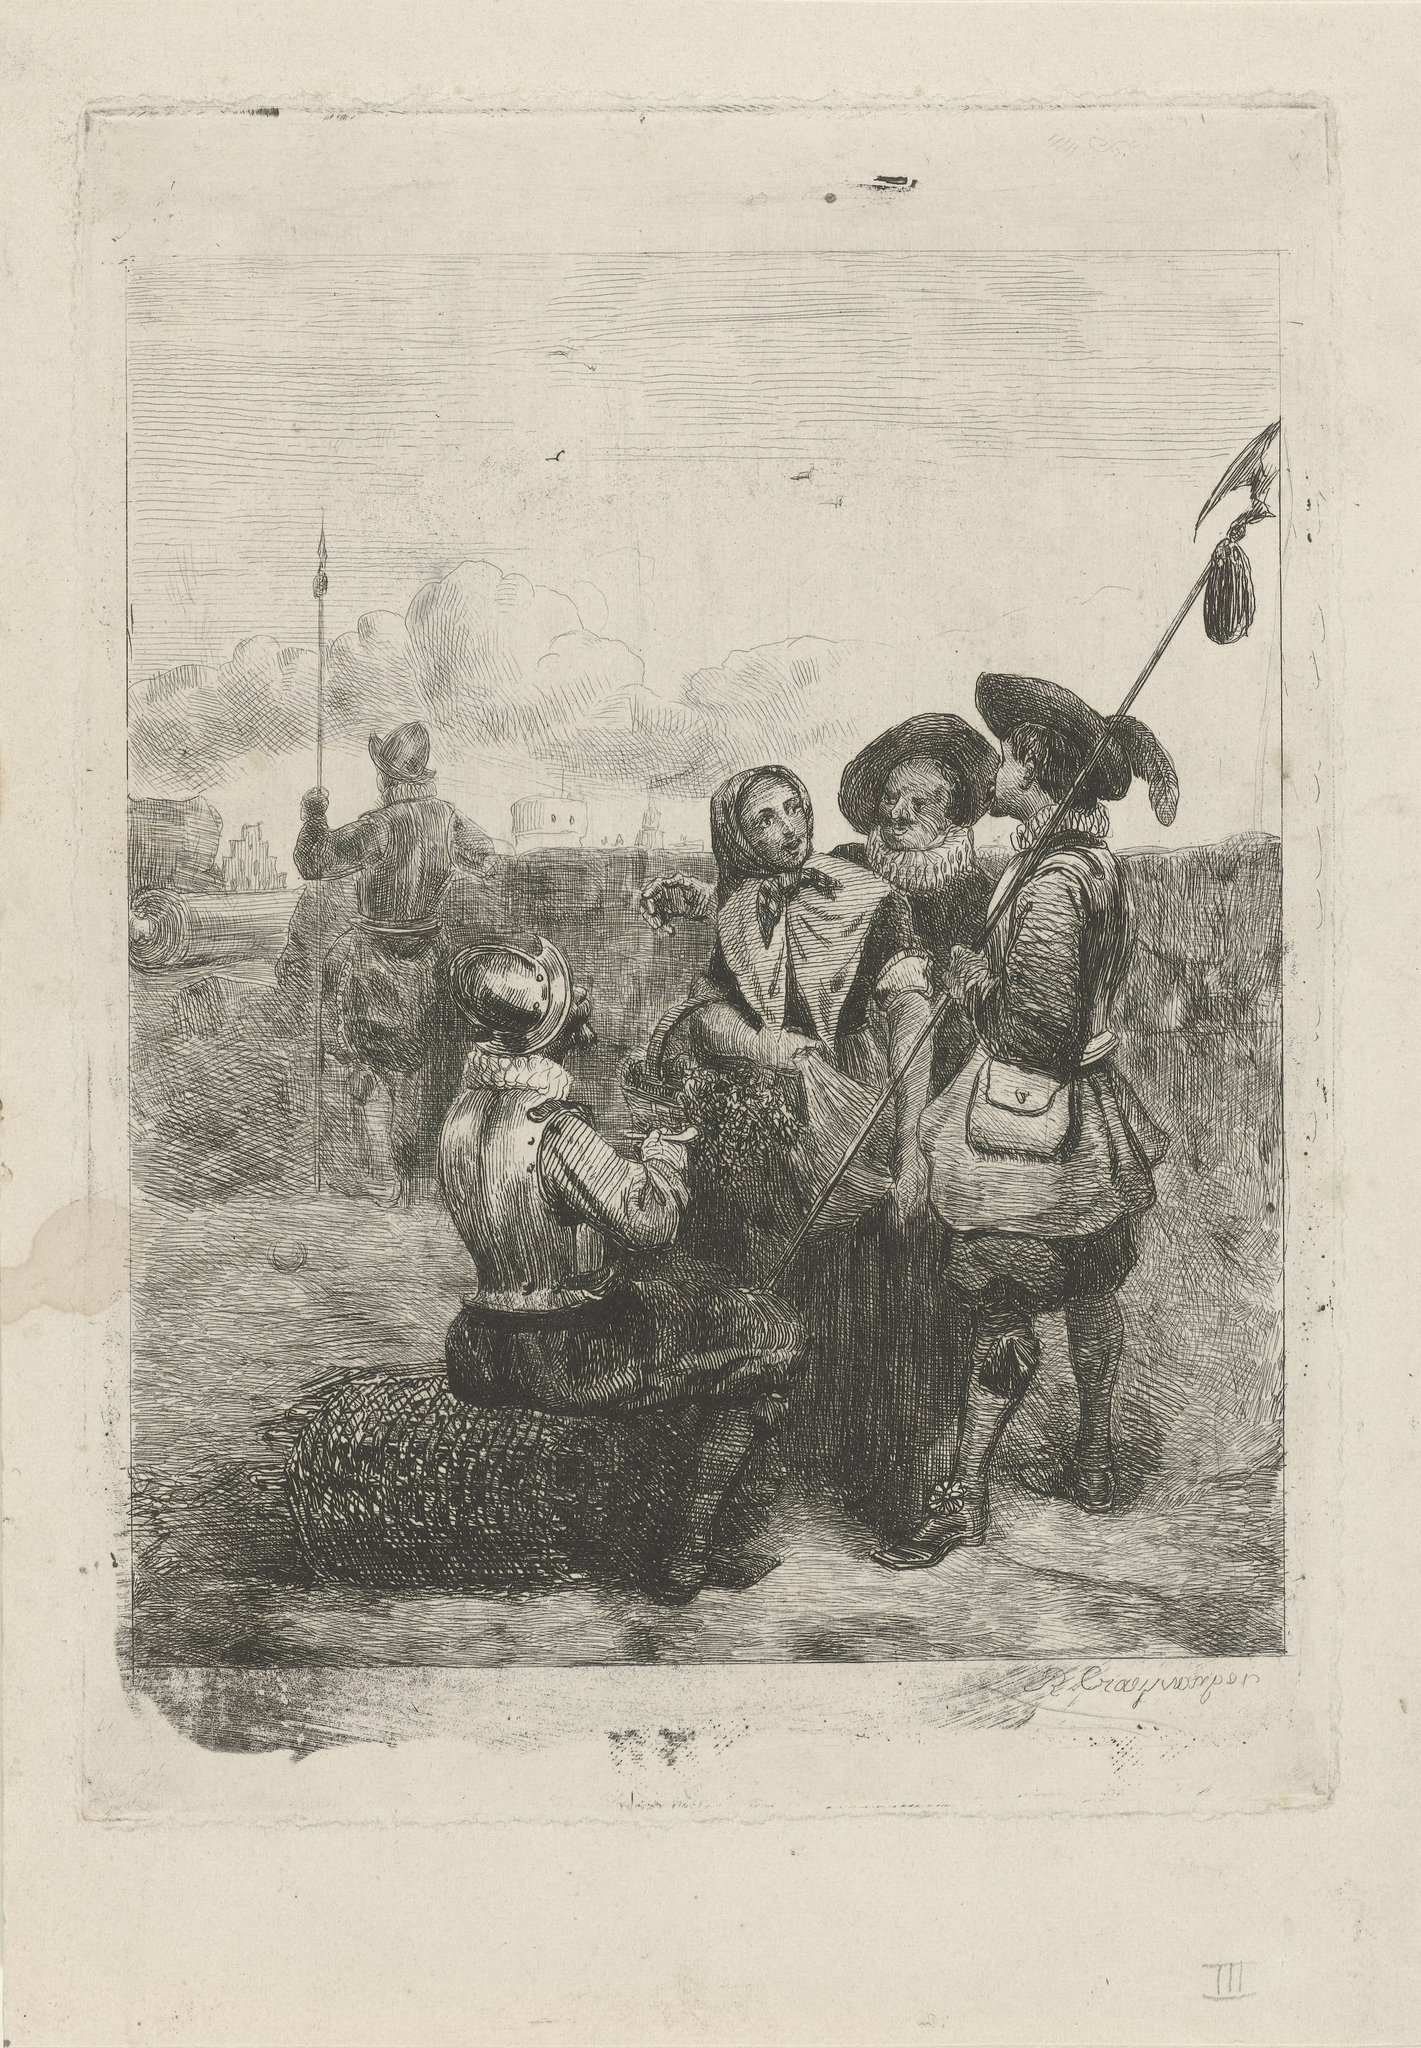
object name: print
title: Soldaten met een jong meisje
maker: reinier craeyvanger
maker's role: draughtsman, print maker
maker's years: 1812-1880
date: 1822-1880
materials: paper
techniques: etching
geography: amsterdam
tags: fortifications, military engineering, firearms: cannon, the soldier; the soldier's life, women camp-followers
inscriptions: collector's mark: Lugt 2228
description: Bovenop een versterking van een stad wordt een jong meisje omringd door drie soldaten. Een van de soldaten zit op een mand en rookt pijp. Op de achtergrond een kanon.